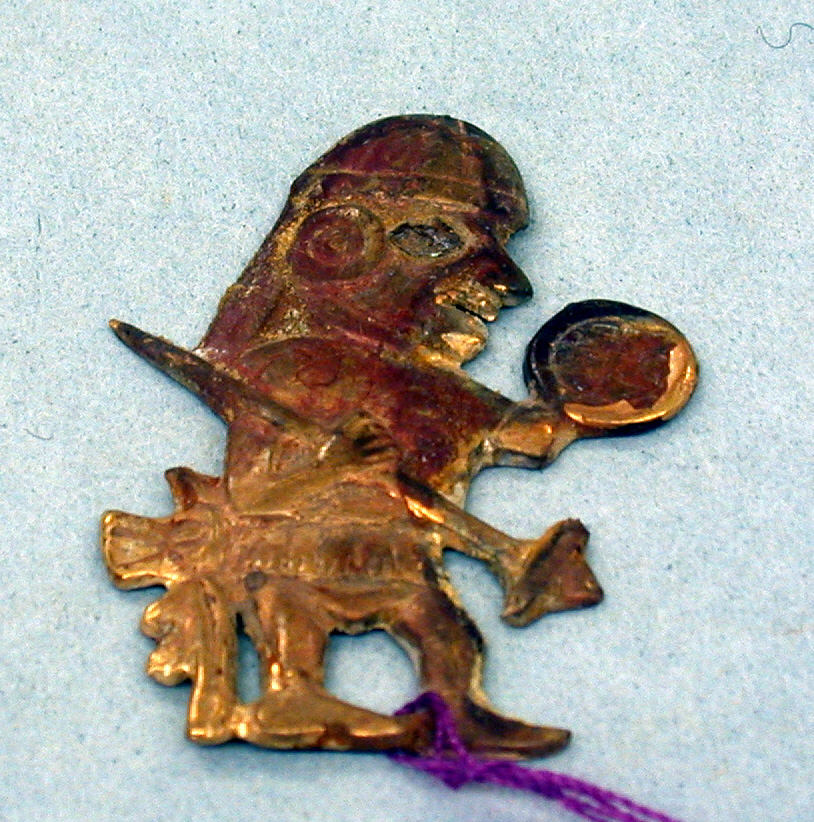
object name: ornament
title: Warrior Ornament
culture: moche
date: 501-700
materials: gold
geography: peru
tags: human figures,weapons